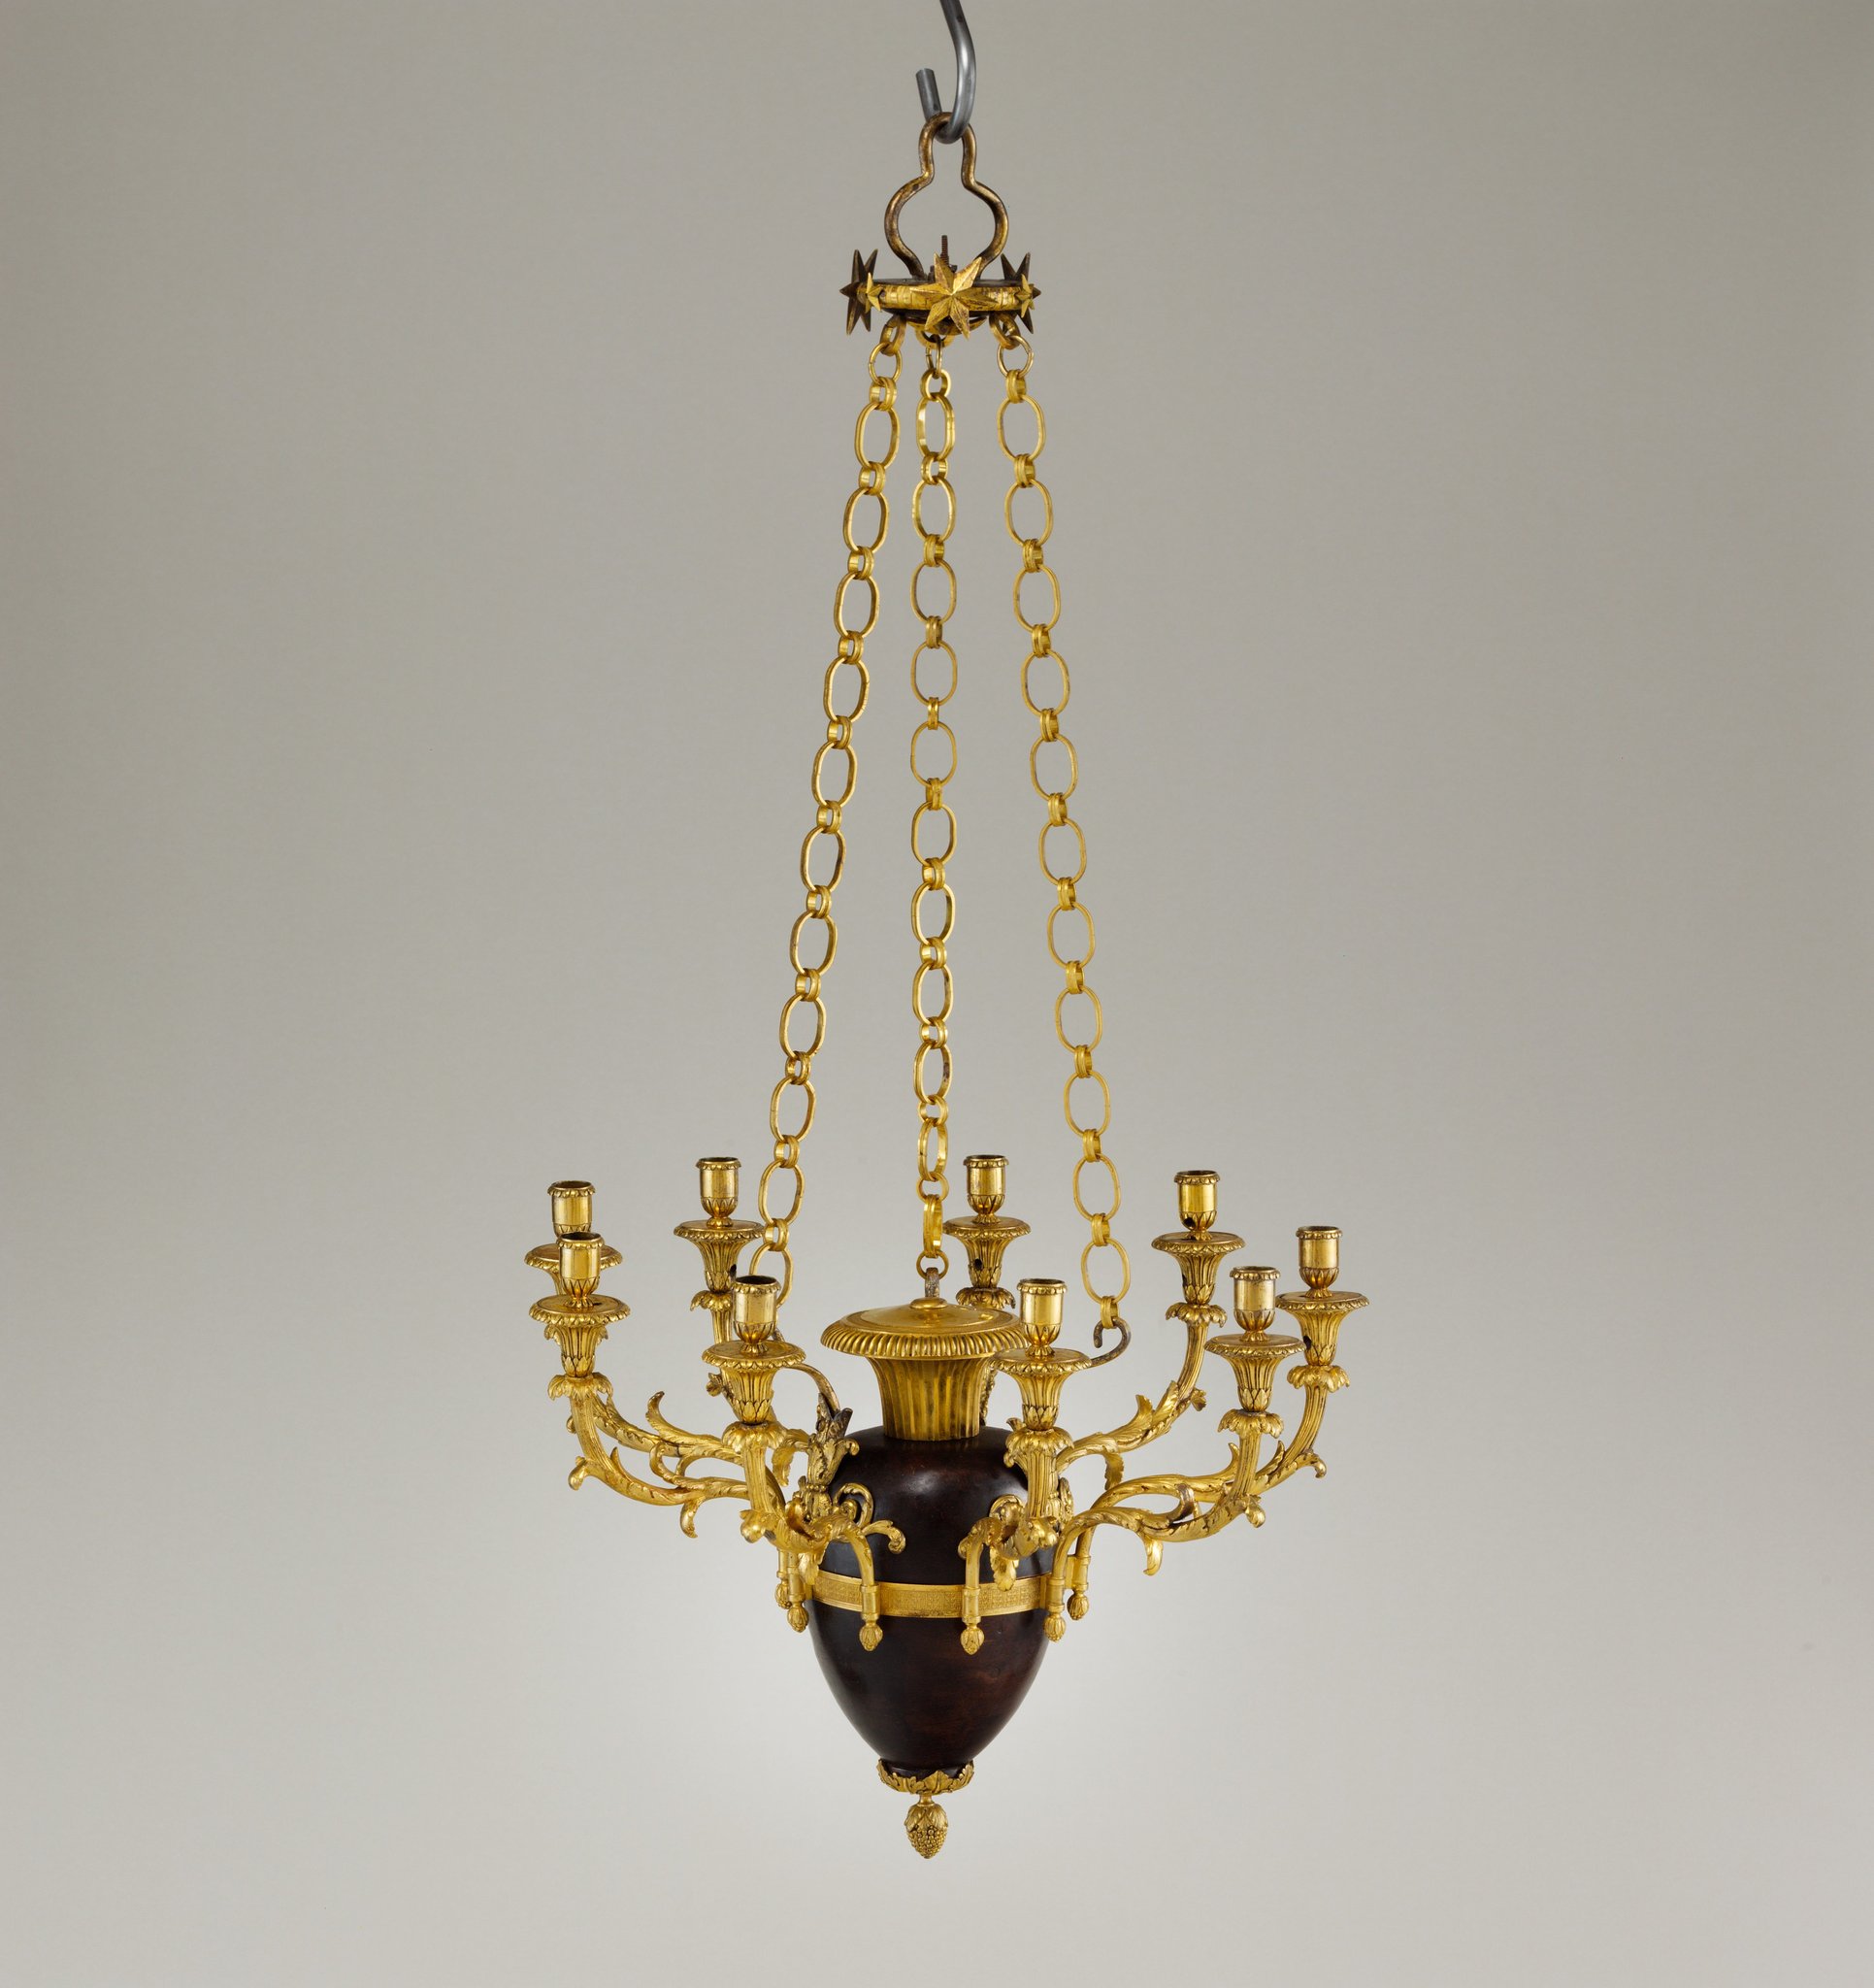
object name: chandelier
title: Nine-light chandelier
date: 1785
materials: bronze, gilt